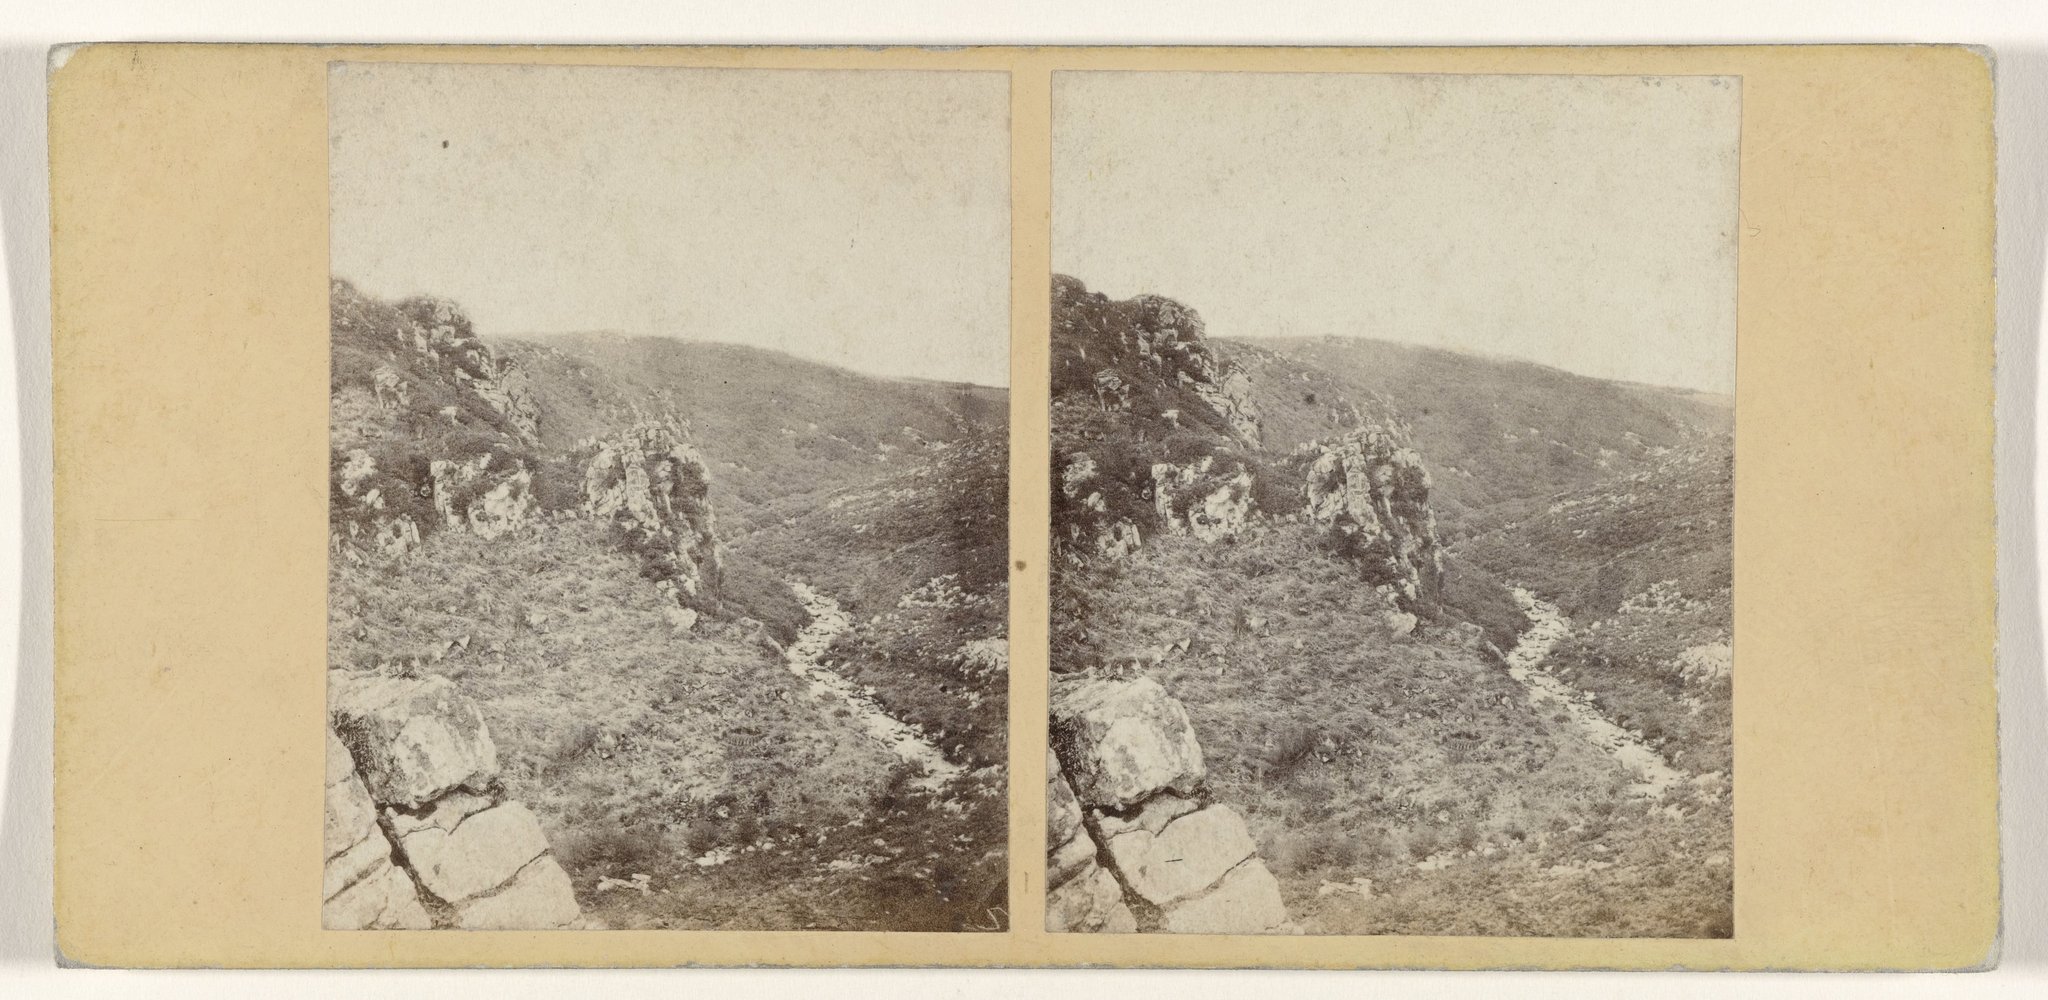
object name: stereograph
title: Dartmoor in Devon, Engeland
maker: william palmer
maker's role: fotograaf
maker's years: 1828-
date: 1861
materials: cardboard, paper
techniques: albumen print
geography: dartmoor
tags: low hill country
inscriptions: inscription: ‘Fothergill process with/ Keenes 4 / bi-lens camera - Ross' lenses/ From Dr Palmer,/ Bracebridge,/ Lincoln.’